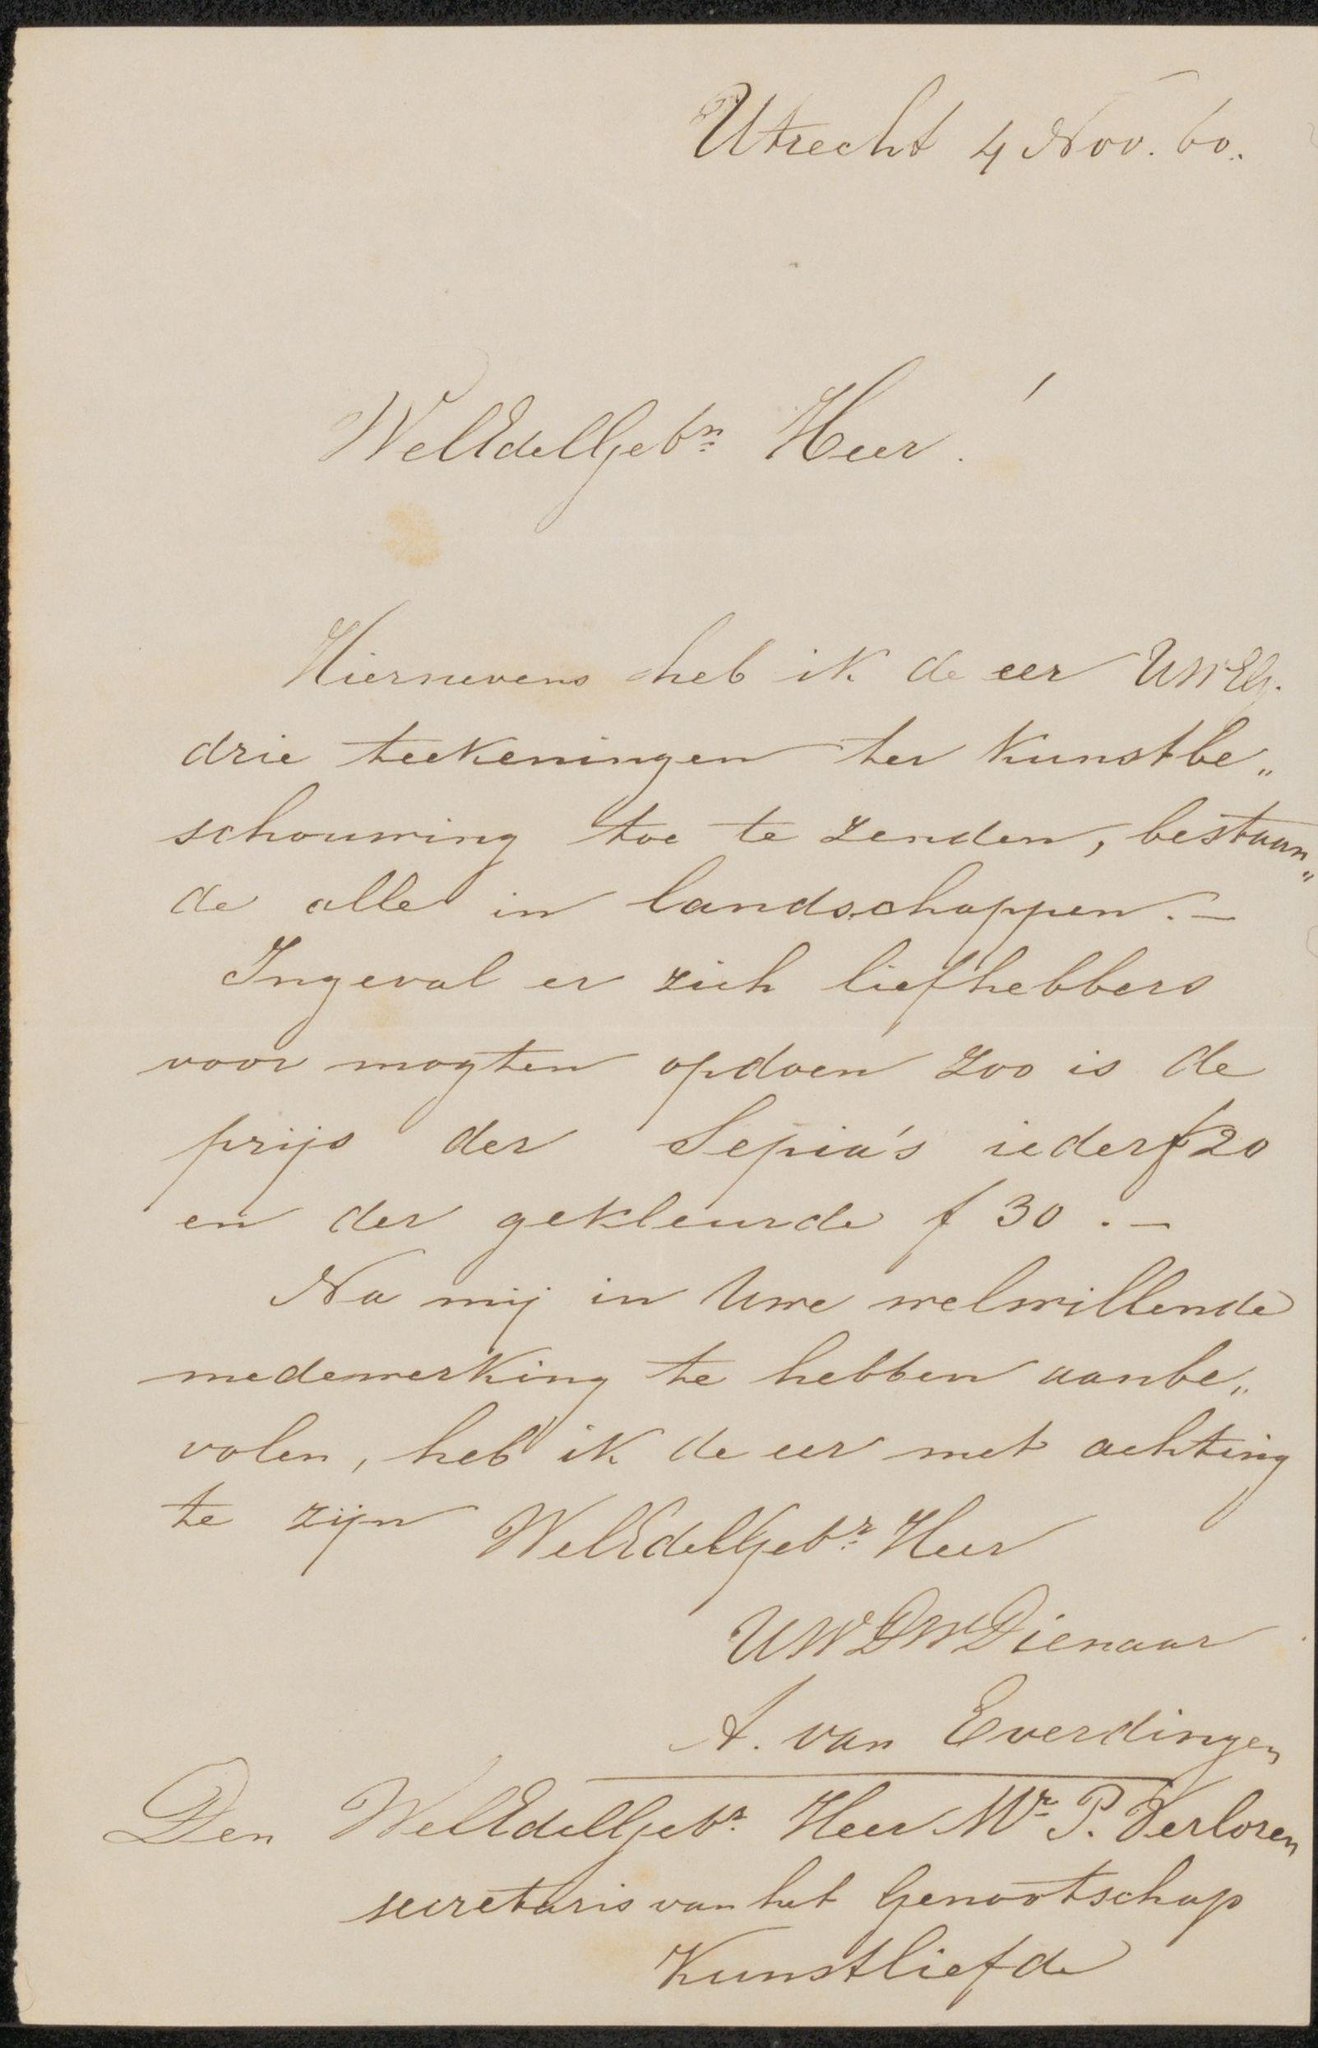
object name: letter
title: Brief aan Pieter Verloren van Themaat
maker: adrianus van everdingen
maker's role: print maker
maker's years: 1832-1912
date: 1860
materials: ink, paper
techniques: pen, writing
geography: utrecht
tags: pieter verloren van themaat, criticizing and discussing art, art criticism, drawing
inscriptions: collector's mark: ‘RPK’